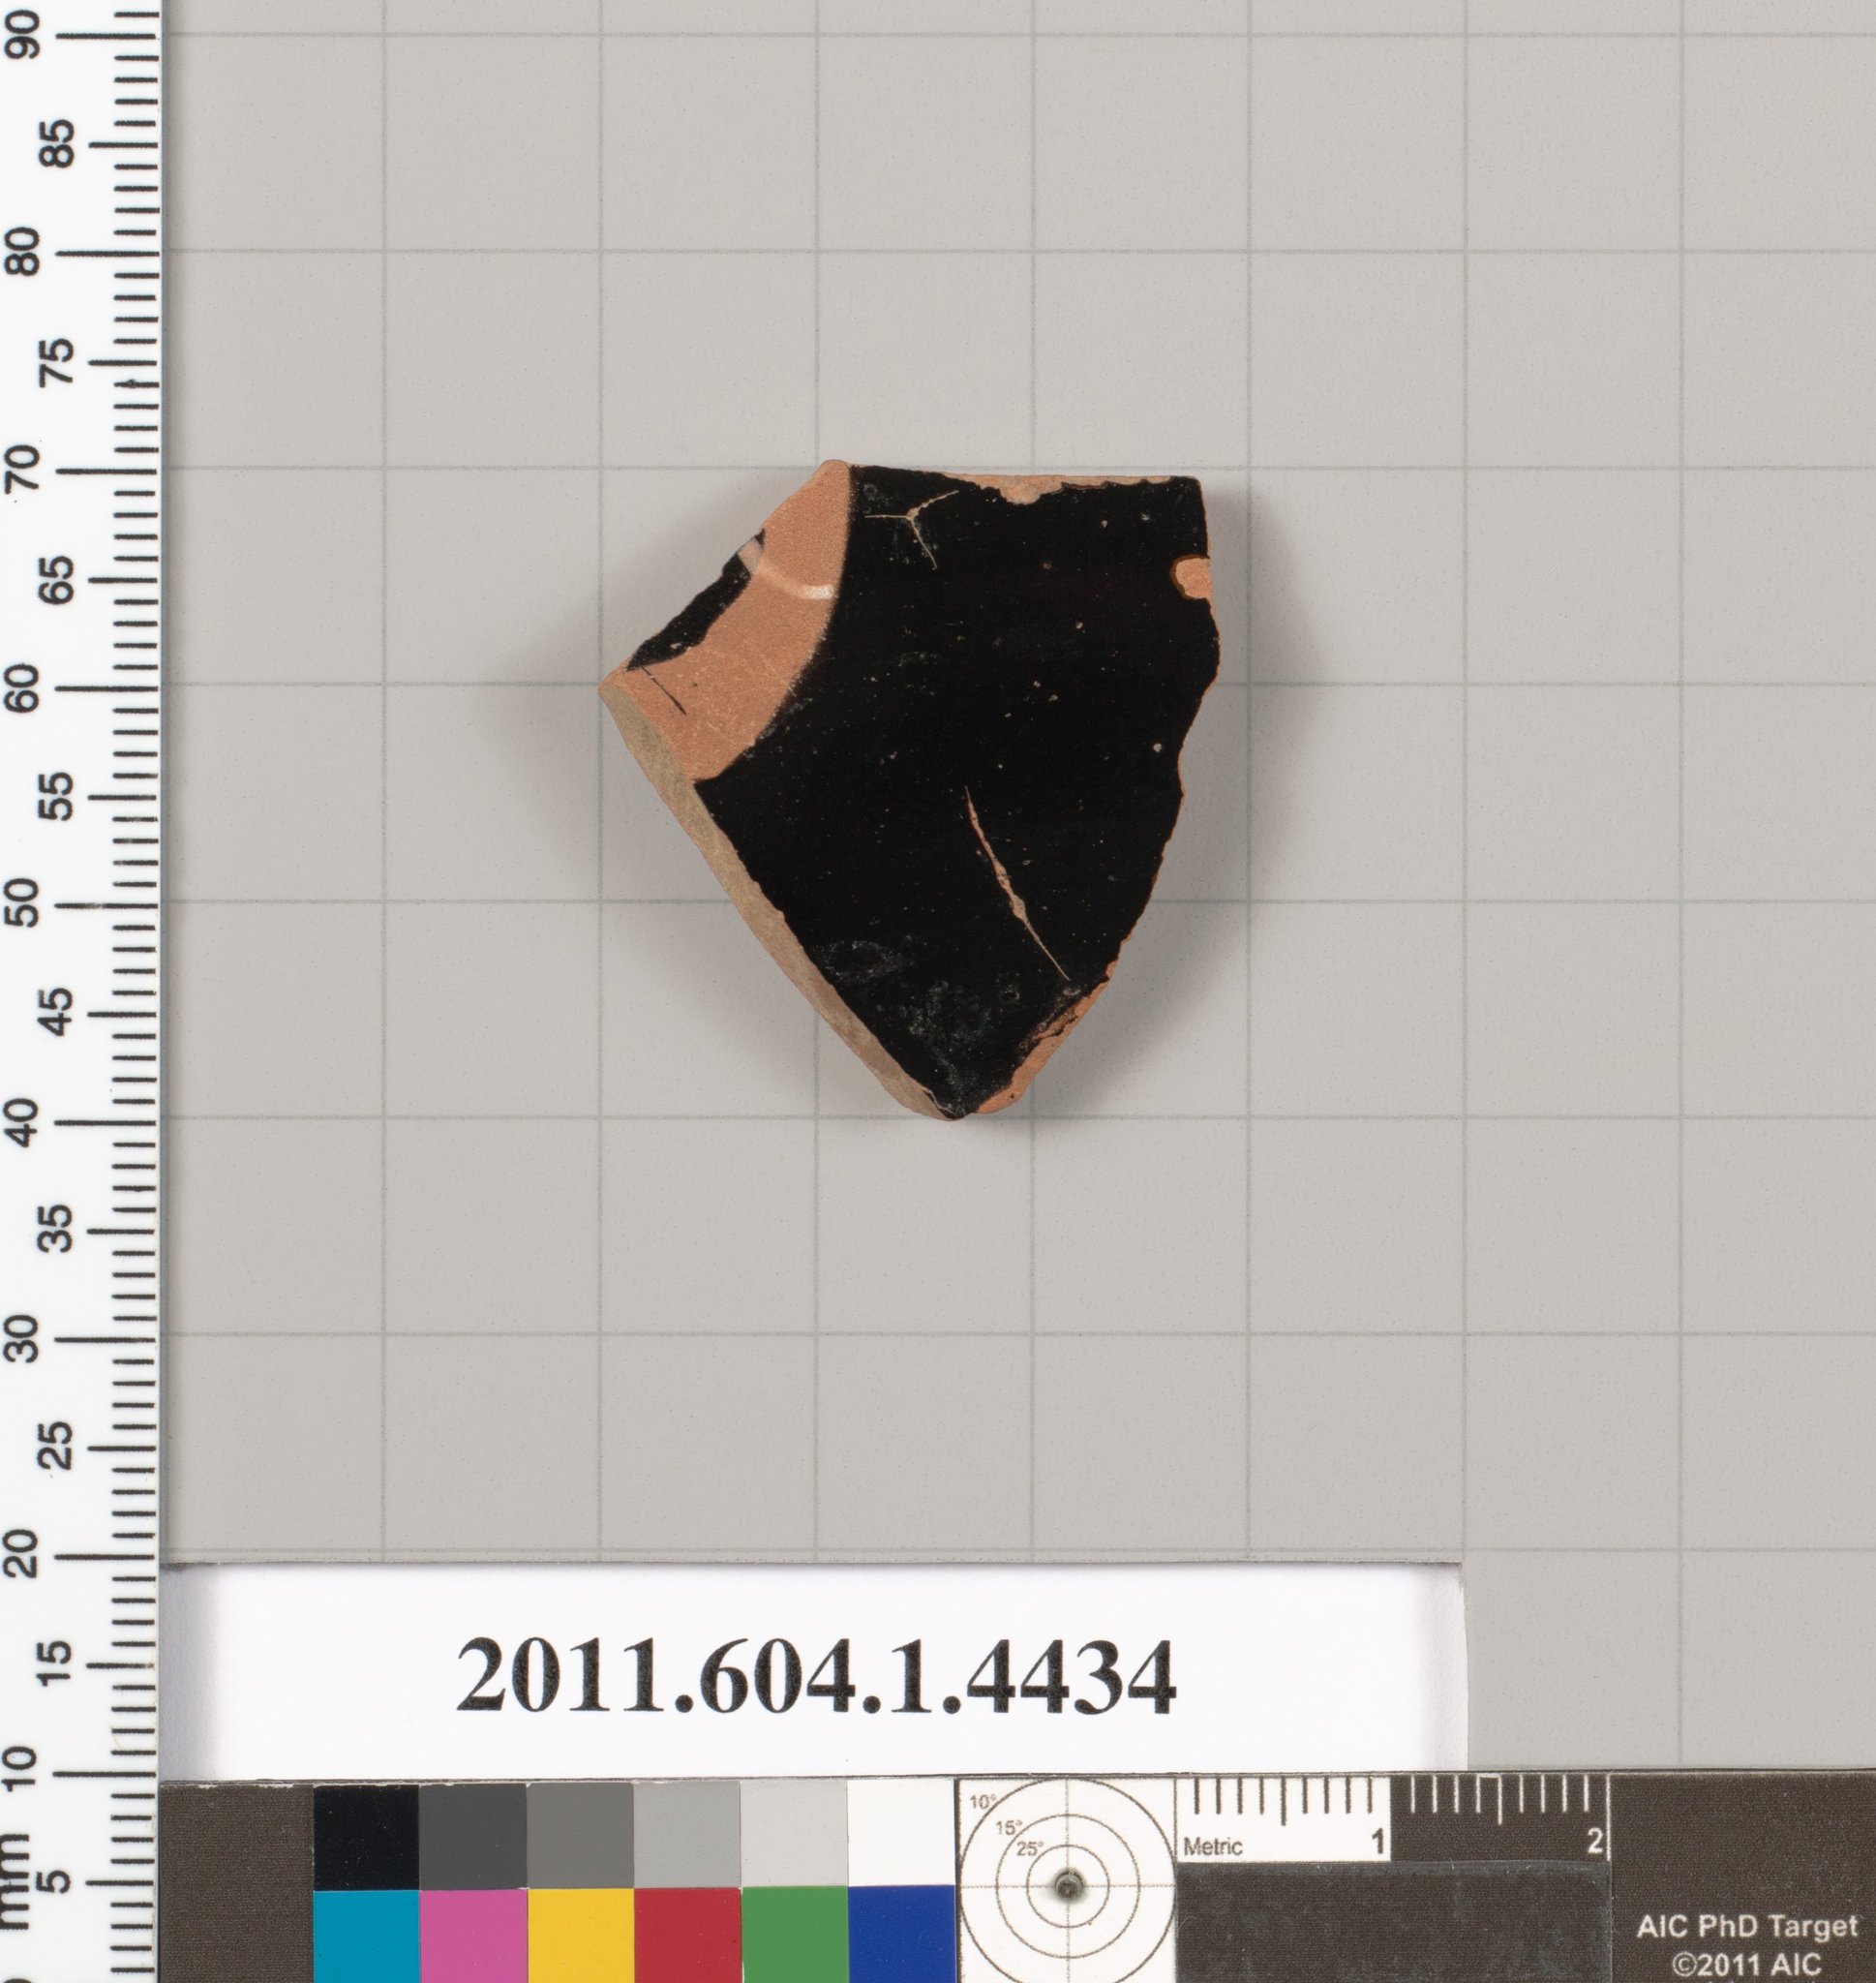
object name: kylix fragment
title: Terracotta fragment of a kylix (drinking cup)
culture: greek, attic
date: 467-435 BCE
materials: terracotta